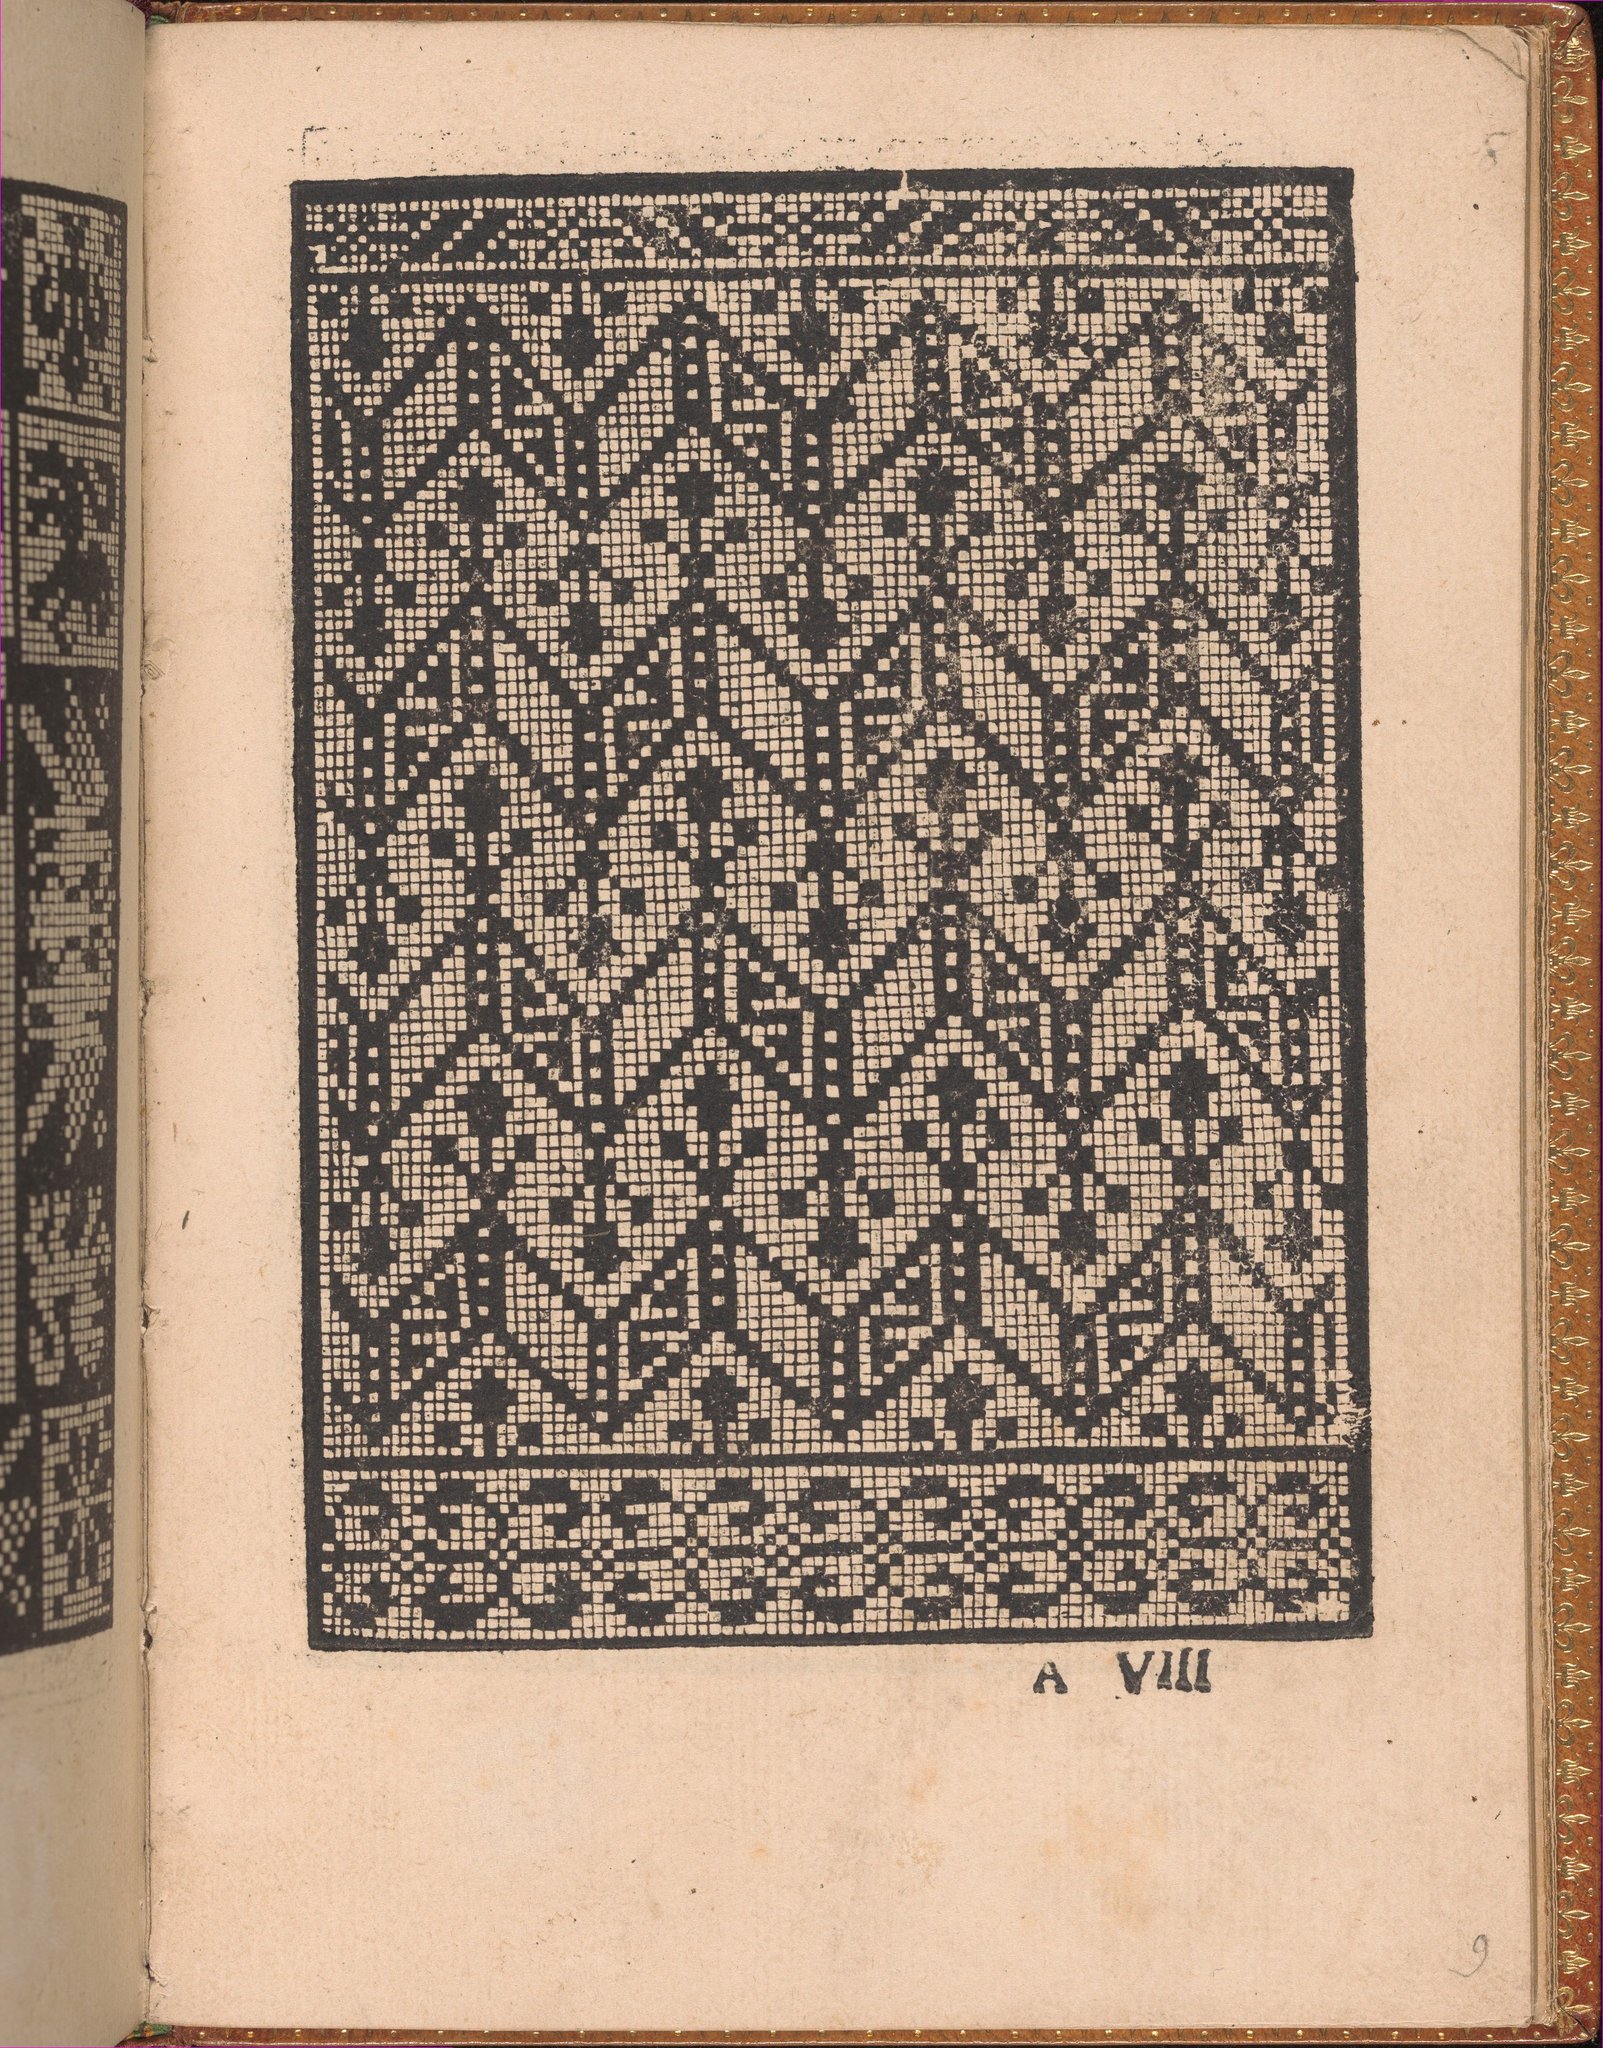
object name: book print ornament architecture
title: Convivio delle Belle Donne, page 9 (recto)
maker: nicolò zoppino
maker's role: publisher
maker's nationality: italian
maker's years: 1478-1544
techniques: woodcut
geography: italy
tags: ornament